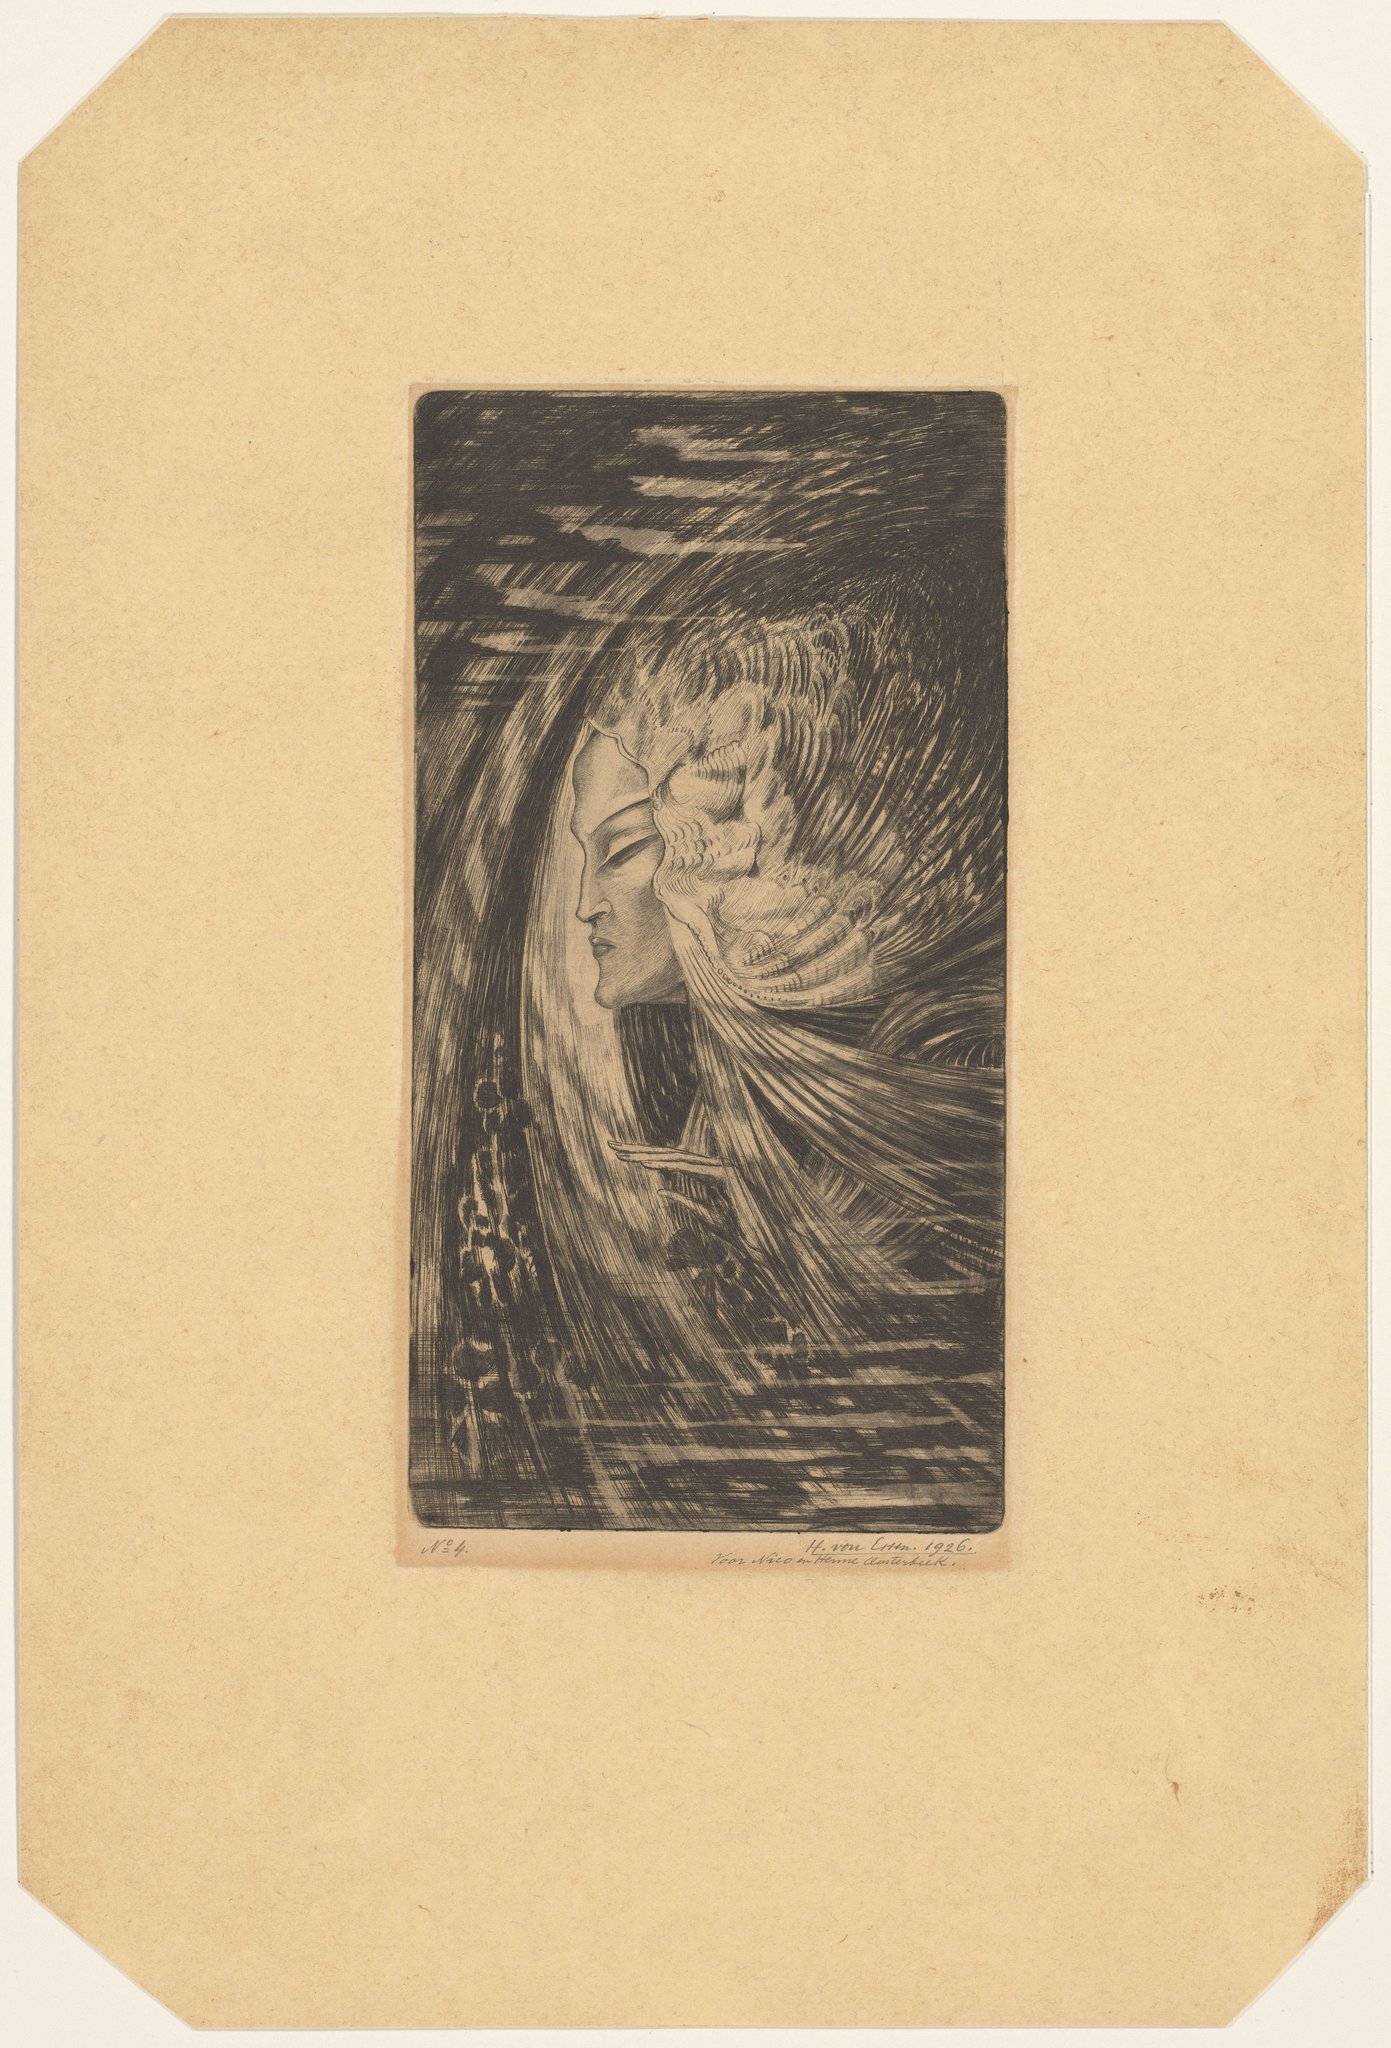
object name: print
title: Verschijning in de sfeer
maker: hein von essen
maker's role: print maker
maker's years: 1886-1947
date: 1901-1926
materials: paper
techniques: drypoint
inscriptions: number: ‘No 4.’, inscription: ‘H von Essen. 1926. / Voor Nico en Hennie Amsterbeek.’